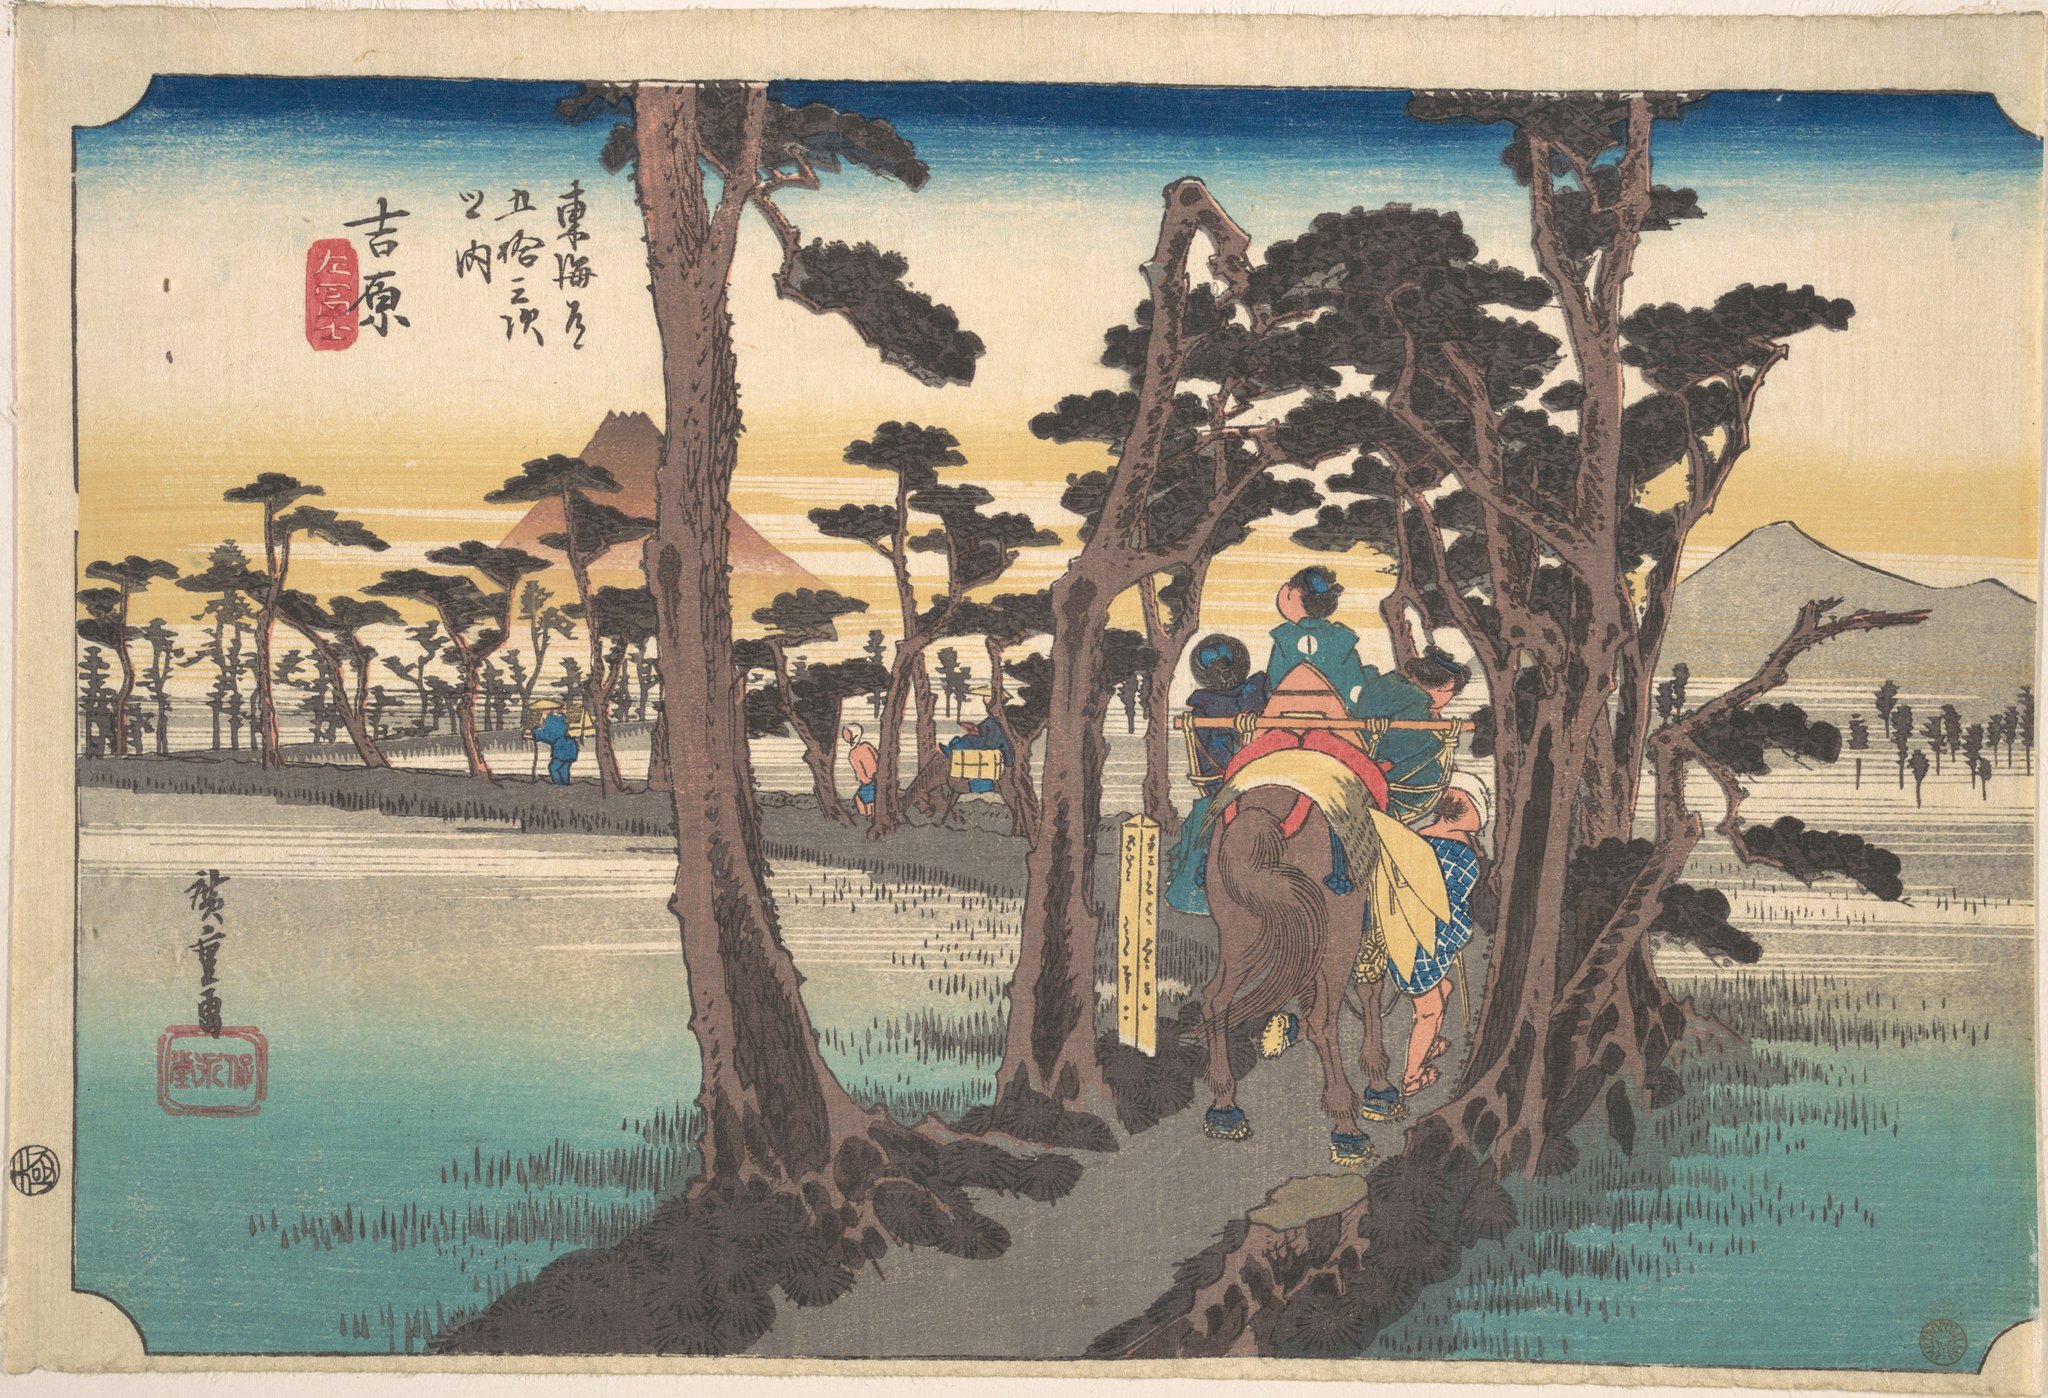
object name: print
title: Yoshiwara, Hidari Fuji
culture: japanese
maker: utagawa hiroshige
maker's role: artist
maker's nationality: japanese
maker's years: 1797-1858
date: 1834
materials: ink, paper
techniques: woodblock print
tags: human figures,animals,landscapes,trees